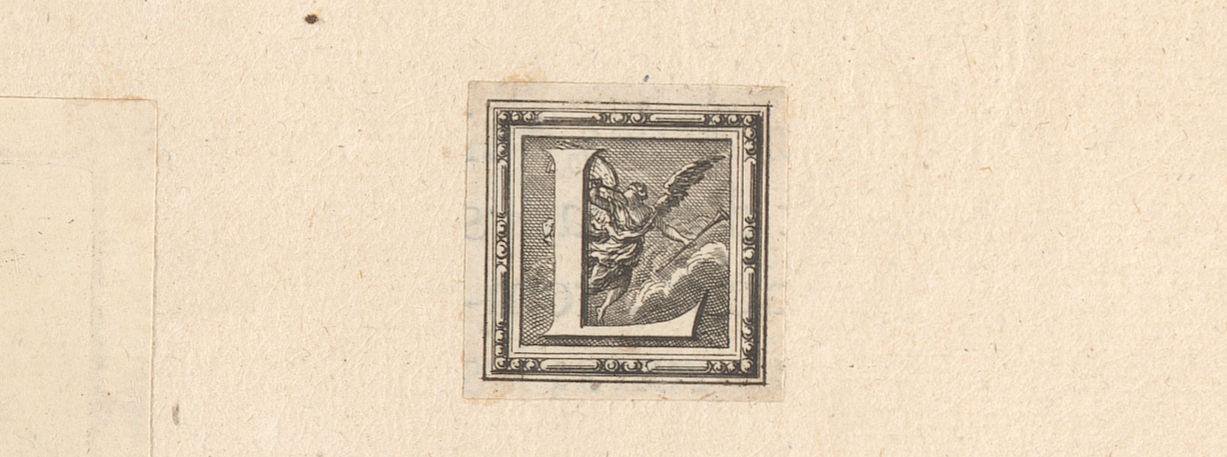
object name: book illustration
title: Initaal 'L' met Fama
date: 1687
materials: paper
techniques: etching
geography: versailles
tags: fame; 'fama', 'fama buona', 'fama chiara' (ripa)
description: Initiaal uit: Rainssant, Pierre. Explication des tableaux de la galerie de Versailles (...). Versailles: François Muguet, 1687.